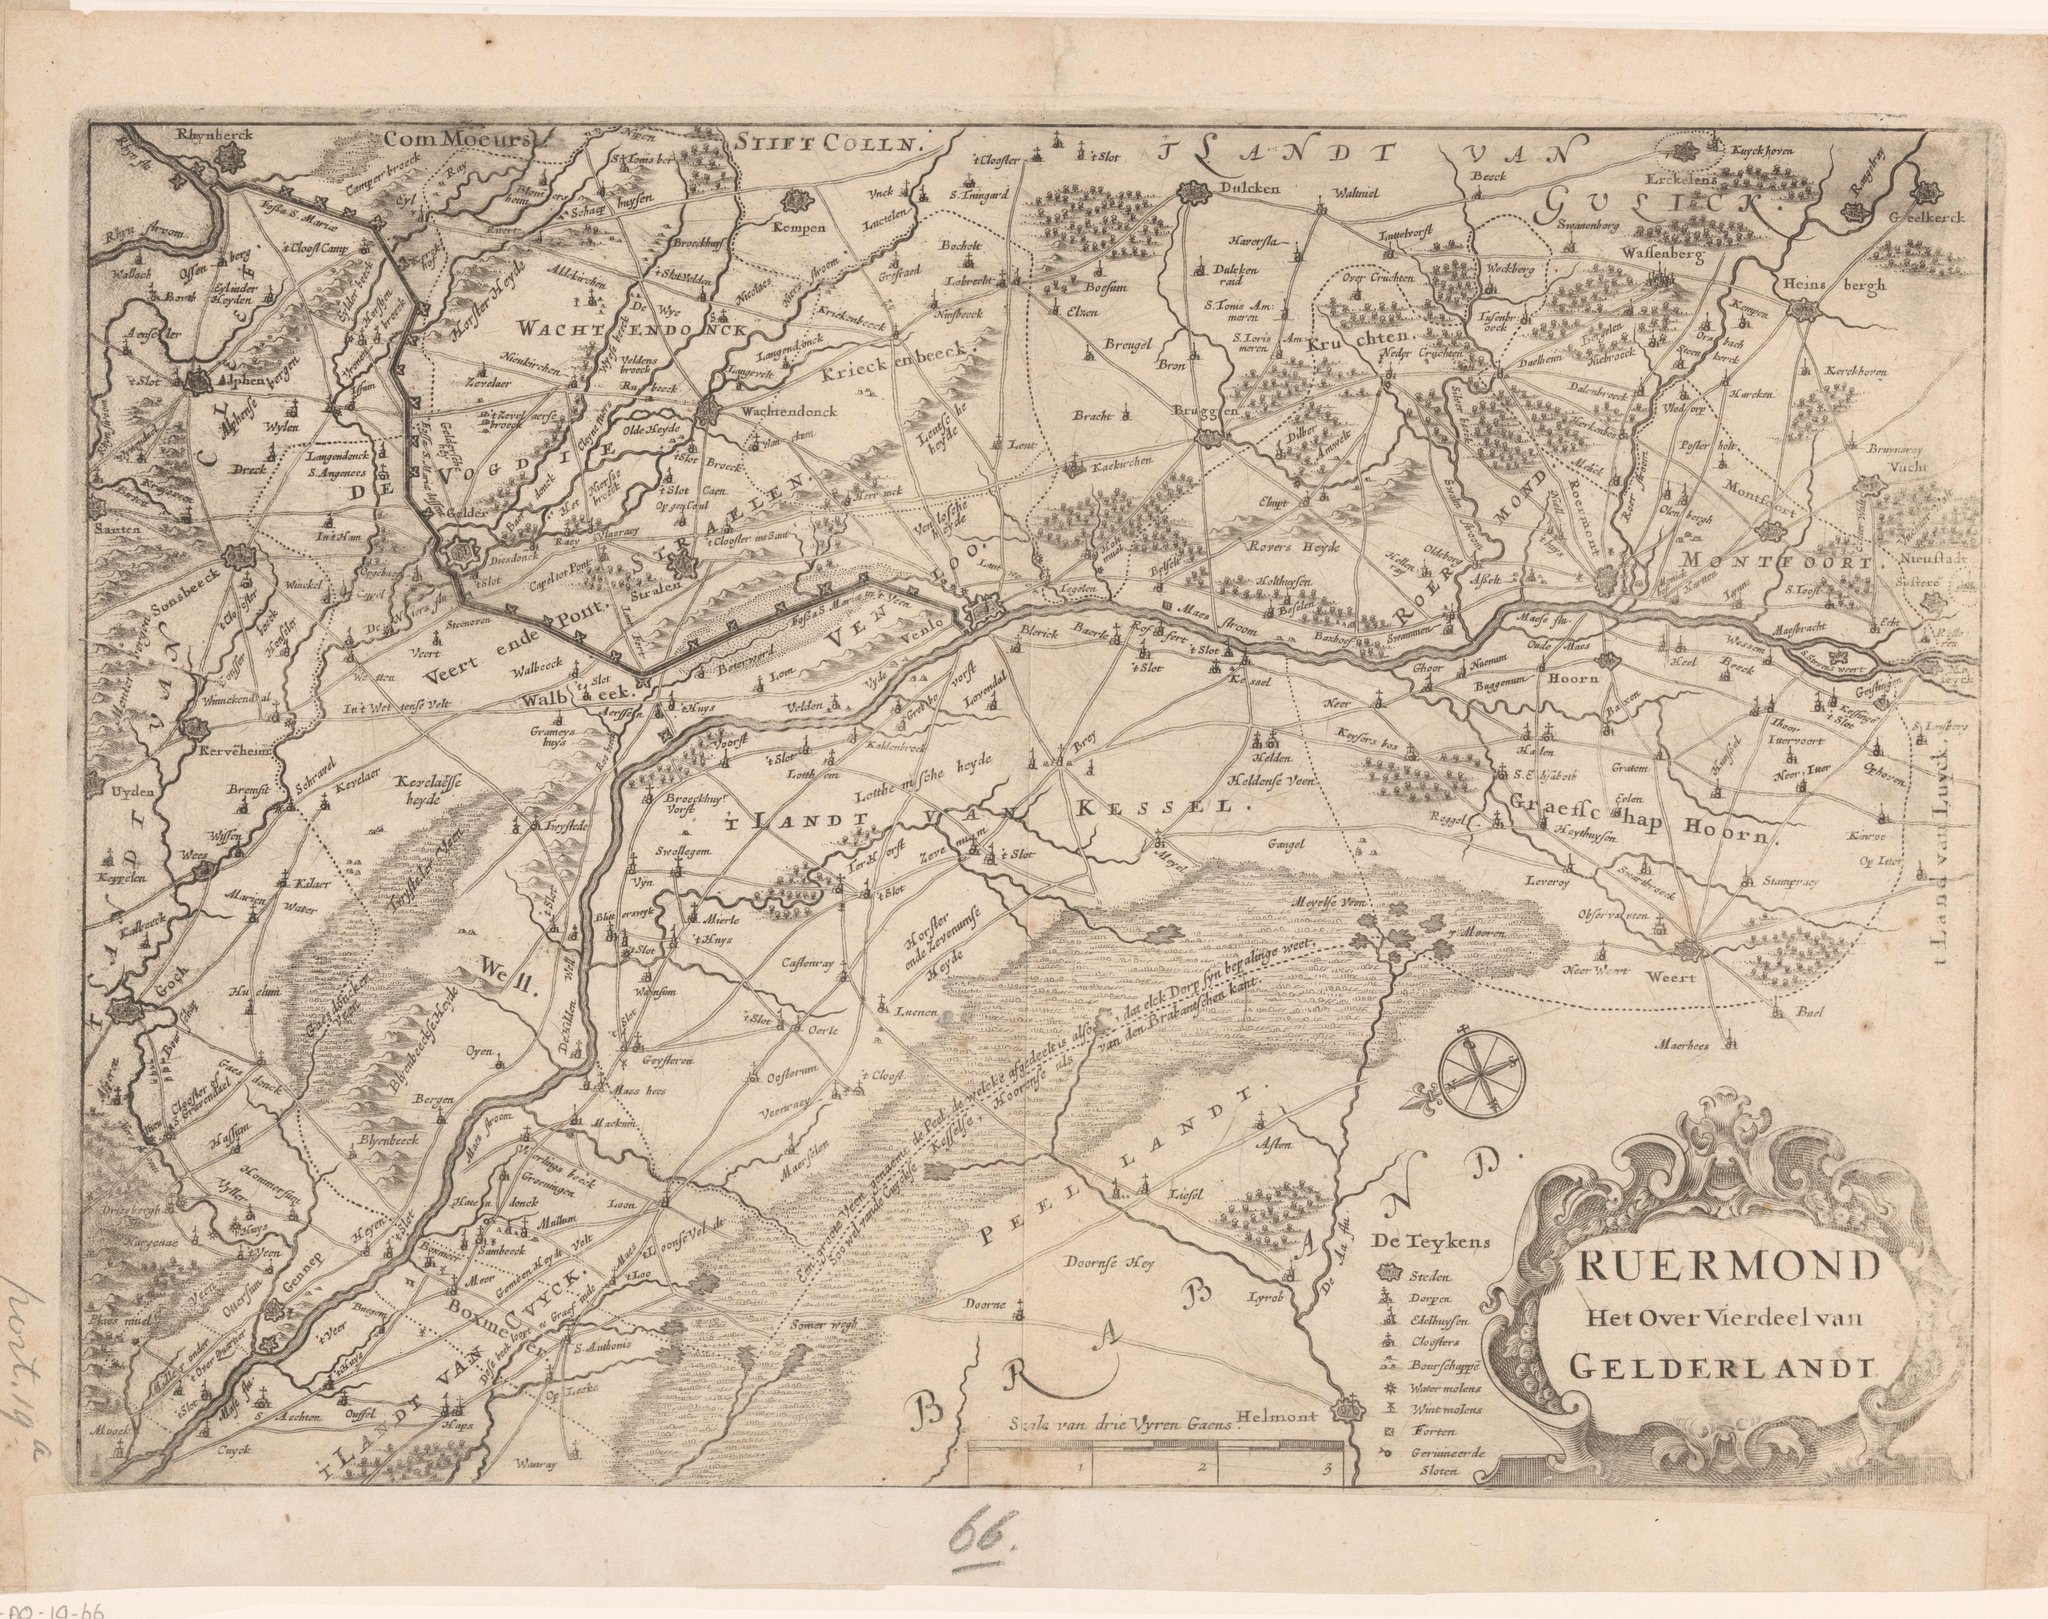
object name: map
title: Kaart van het Kwartier van Roermond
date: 1653-1654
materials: paper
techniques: engraving, etching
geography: arnhem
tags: maps of separate countries or regions, upper guelders, guelders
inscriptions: collector's mark: Lugt 2228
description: Prent ook gebruikt in: Slichtenhorst, Arend. XIV. Boeken van de Geldersse geschiedenissen: van 't begin af vervolghd tot aen de afzweeringh des konincx van Spanien (...). Arnhem: Jacob van Biesen, 1653. En in: Slichtenhorst, Arend. XIV. Boeken van de Geldersse geschiedenissen: van 't begin af vervolghd tot aen de afzweeringh des konincx van Spanien (...). Arnhem: Jacob van Biesen, 1654.